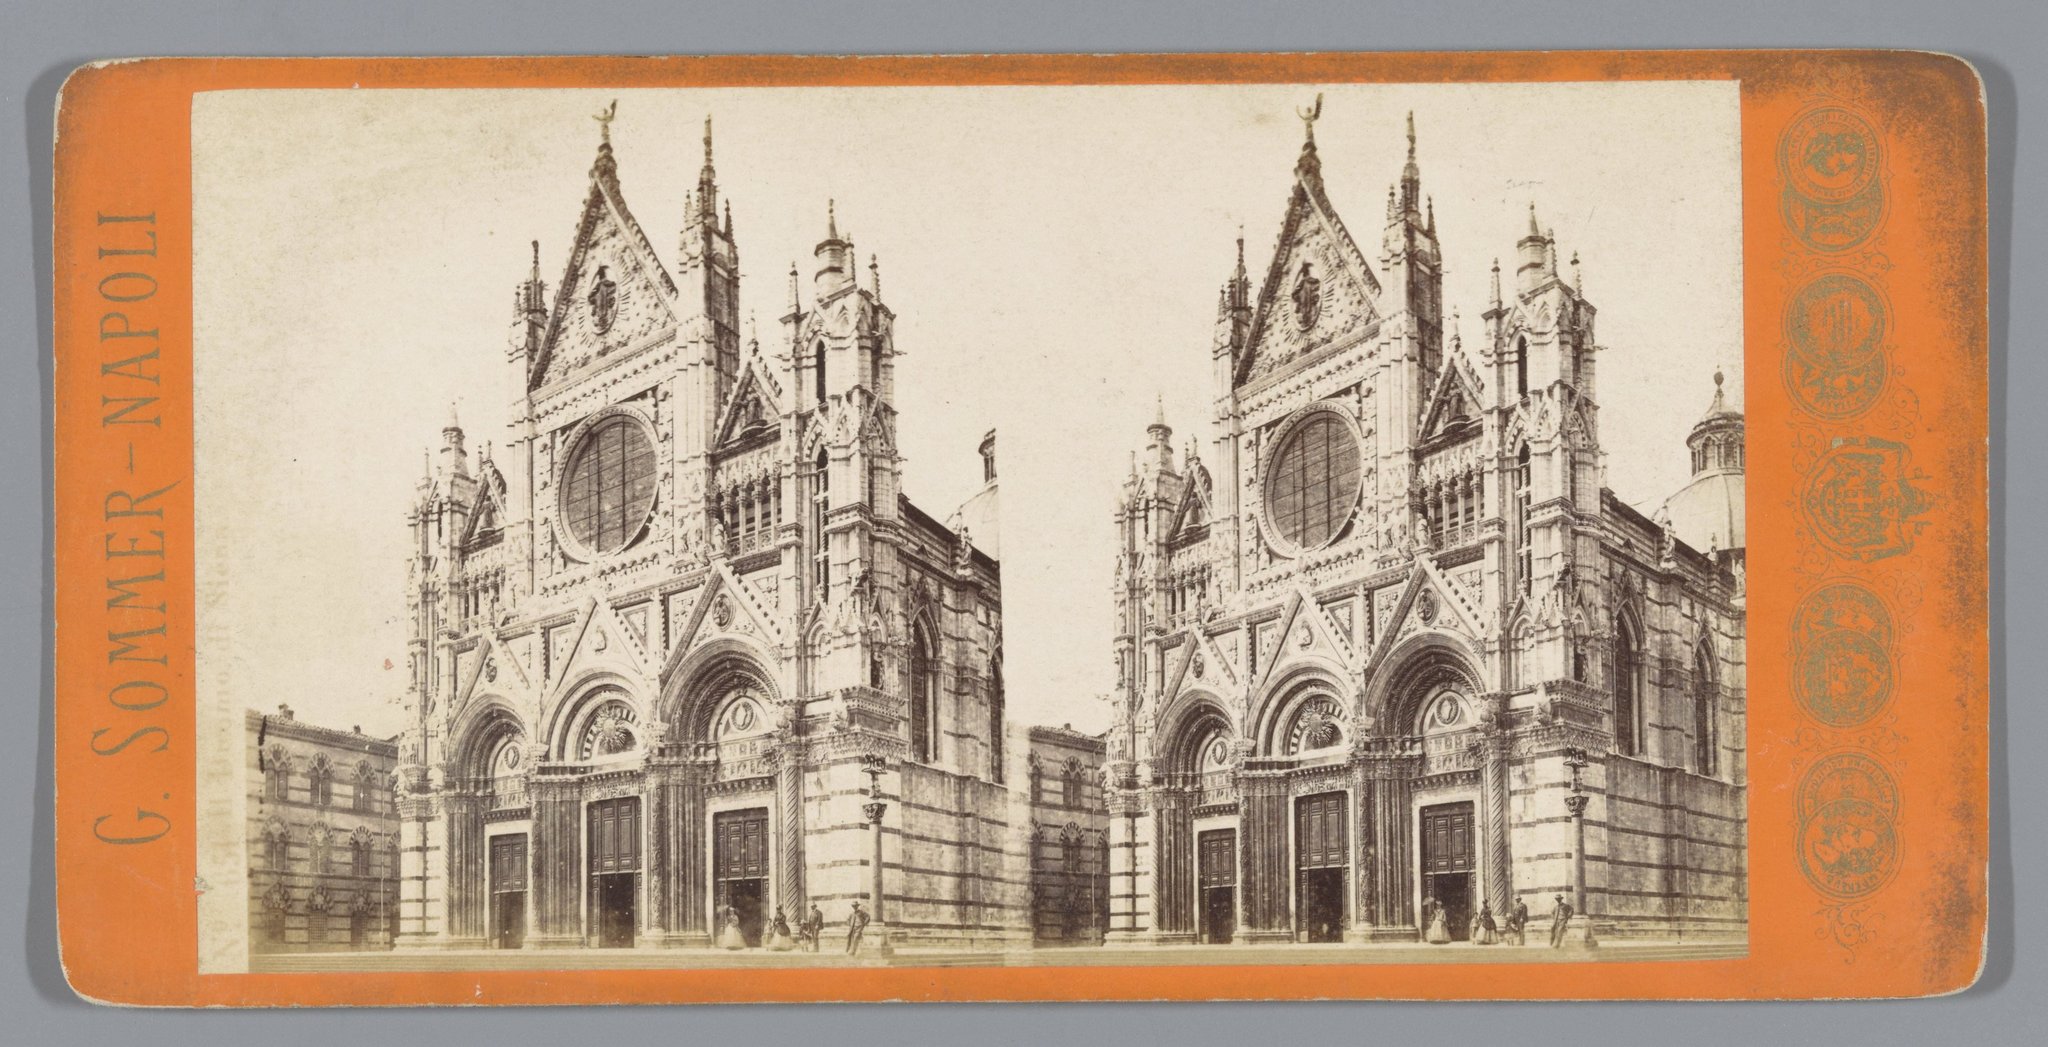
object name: stereograph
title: Gezicht op de Dom van Siena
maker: giorgio sommer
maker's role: fotograaf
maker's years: 1834-1914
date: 1860-1880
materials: cardboard, photographic support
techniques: albumen print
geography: siena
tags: church (exterior)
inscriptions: inscription: ‘Siena : Dom’, number: ‘No. 654’